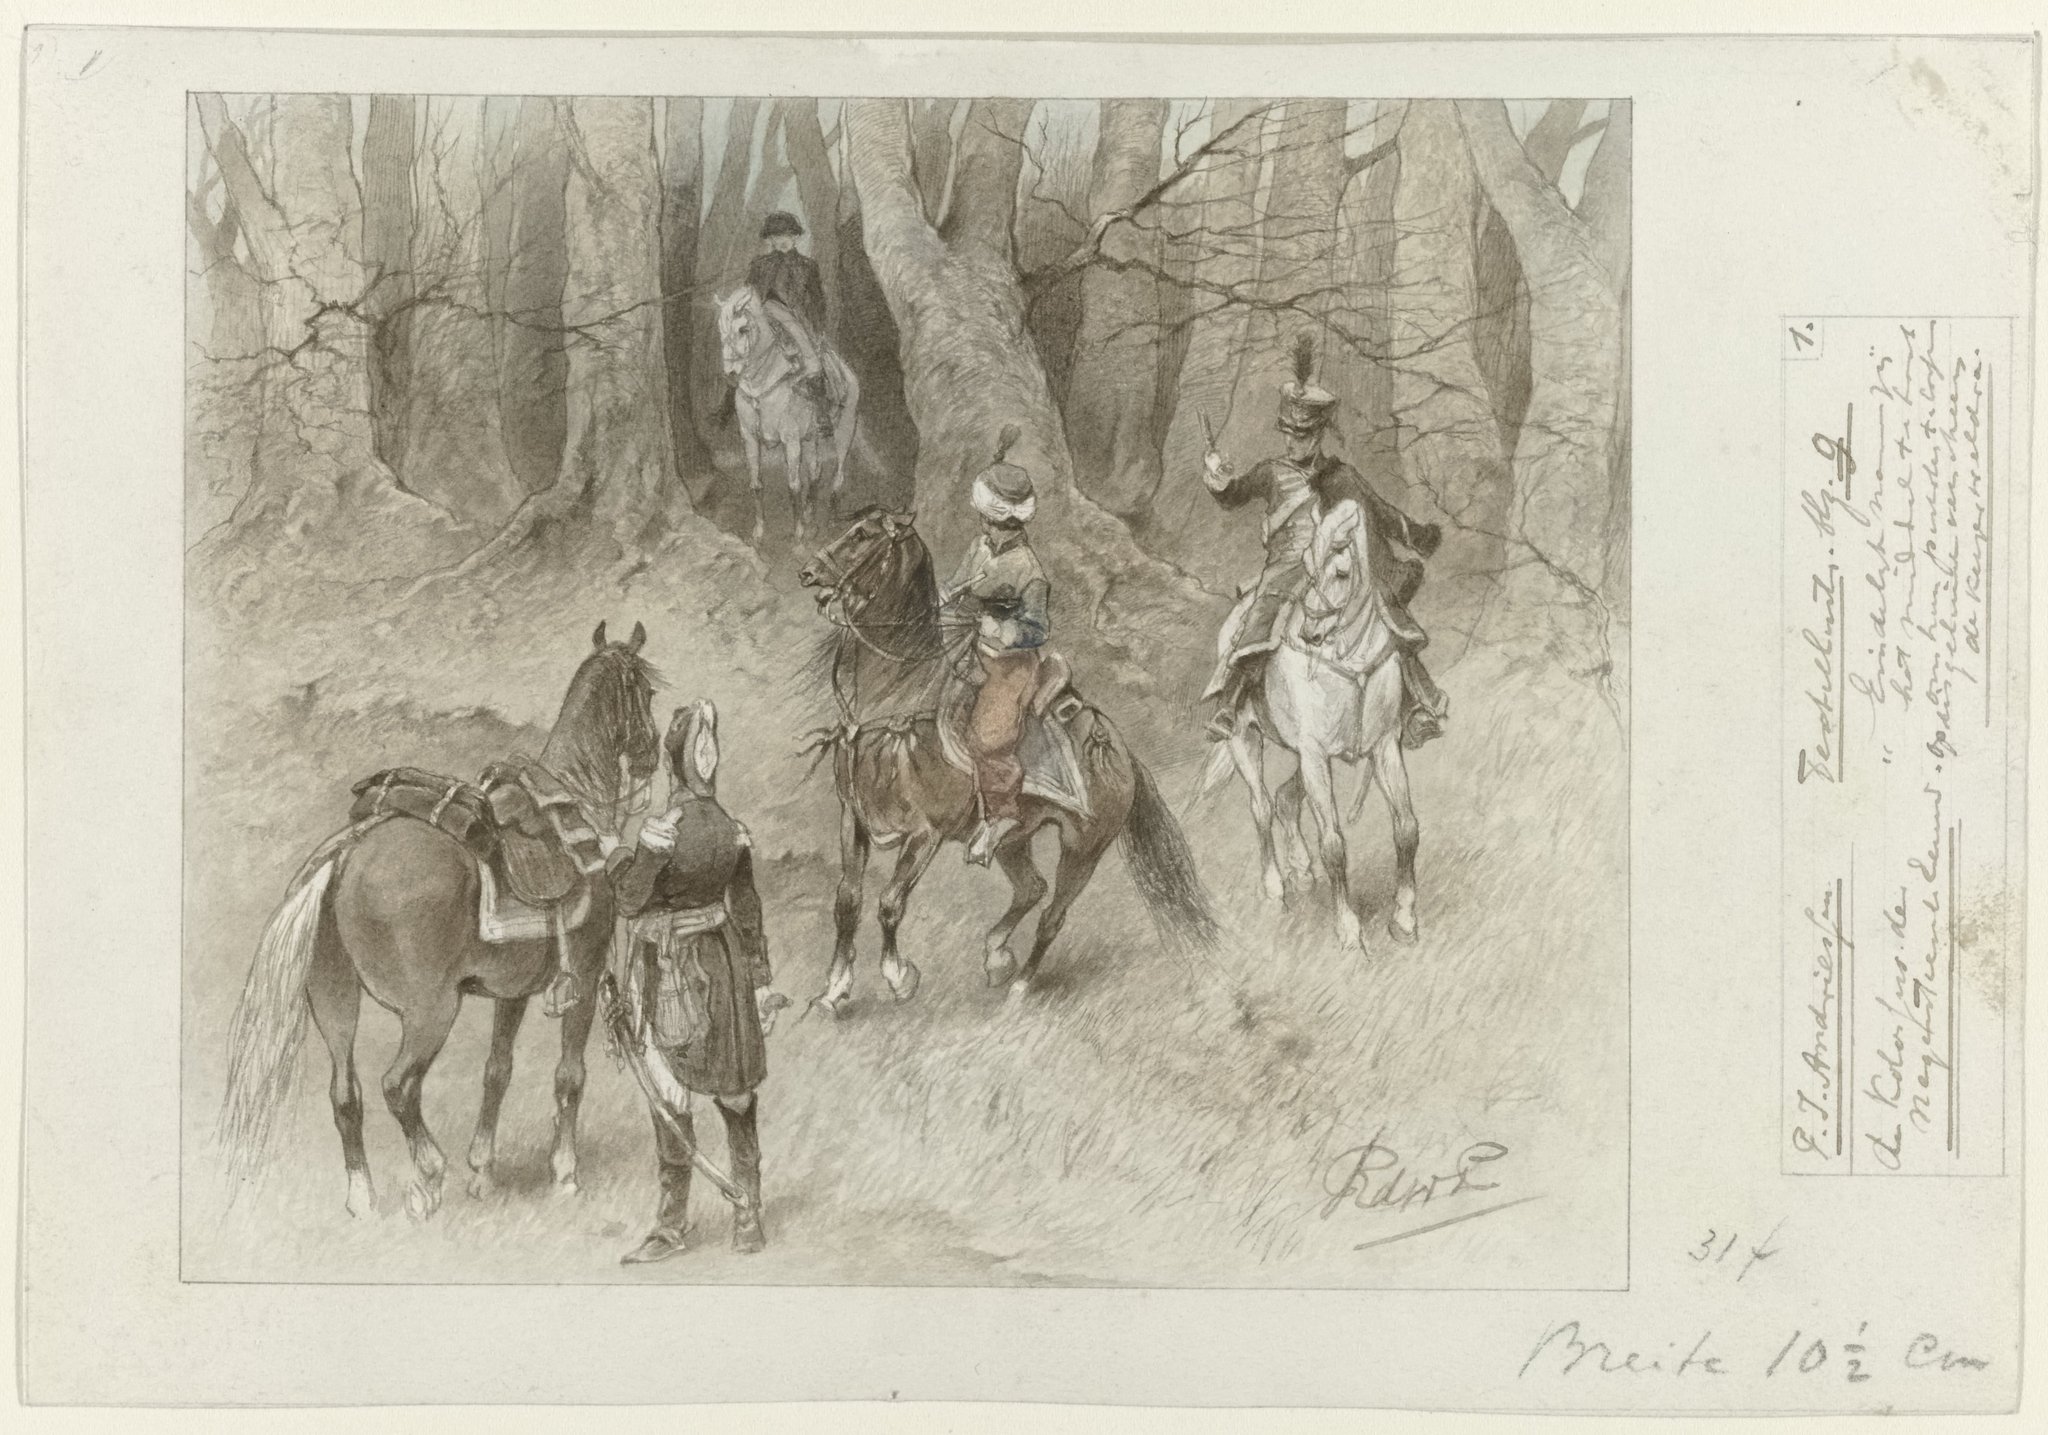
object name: drawing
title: Ontwerp voor illustratie voor De Kolossus der Negentiende Eeuw door P.J. Andriessen (Textill., blz. 9); scène uit het leven van Napoleon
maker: george lodewijk de wetstein pfister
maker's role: draughtsman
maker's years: 1867-1942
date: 1877-1942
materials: ink, paper, pencil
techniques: brush, pen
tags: napoleon i (emperor of the french), (andriessen, de kolossus der negentiende eeuw) specific works of literature (with author, title), historical persons, illustration ~ printed matter, book, historical events and situations